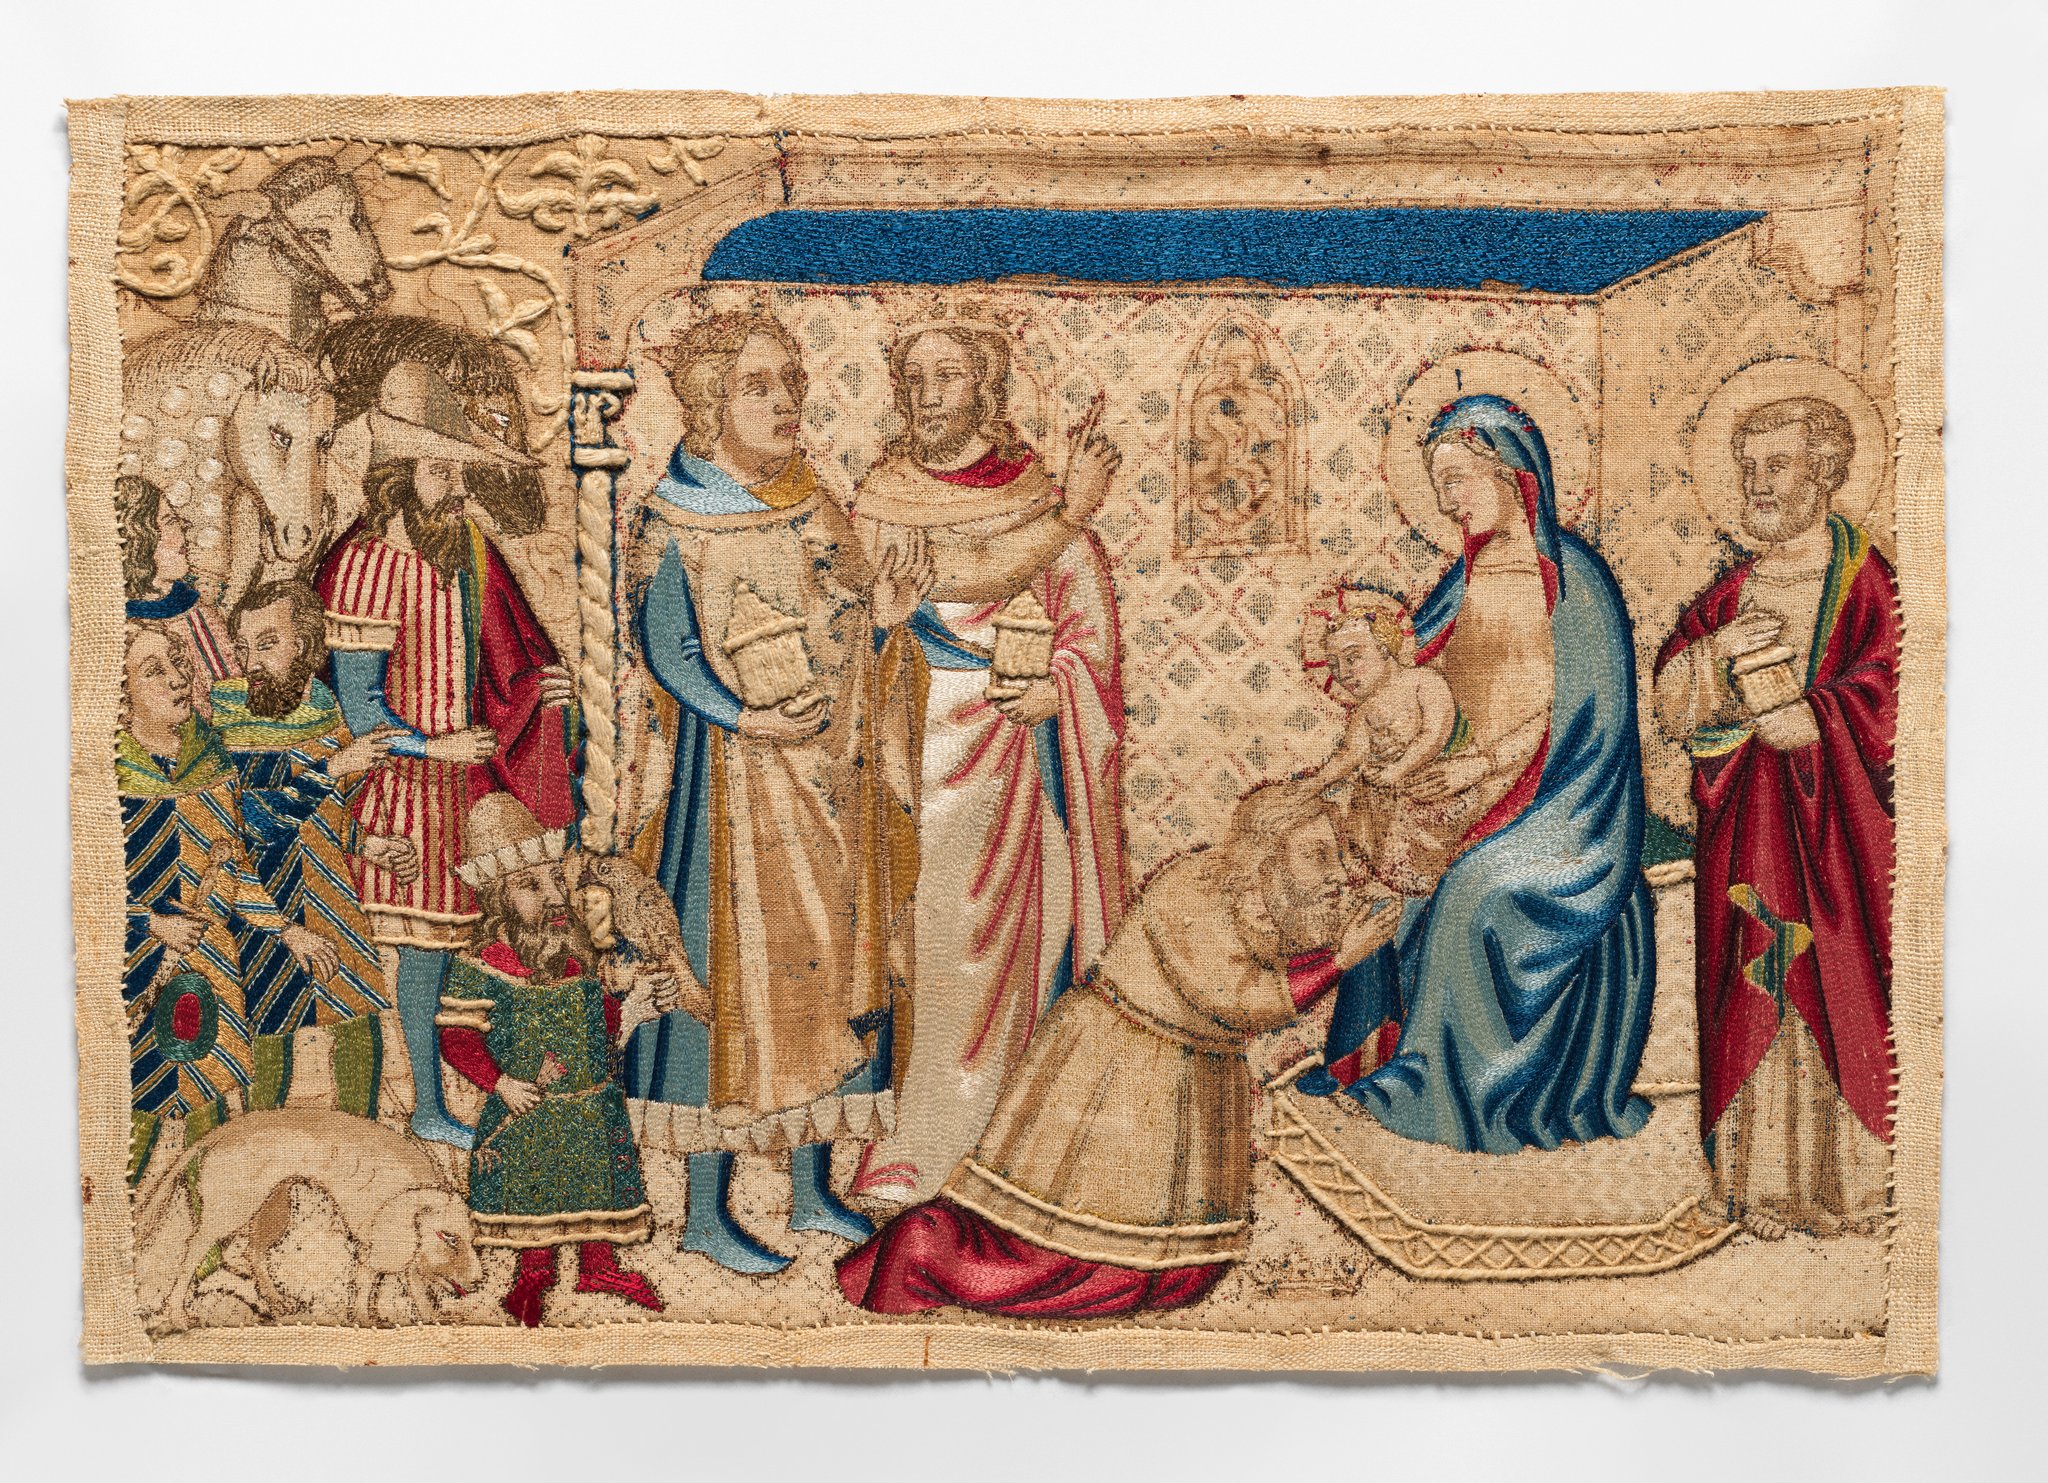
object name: orphrey, textile cover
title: The Adoration of the Magi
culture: italian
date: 1367-1400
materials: cotton, gilt, hemp, ink, linen, metal, silk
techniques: embroidery, laid work, weave, stitching, drawing, wash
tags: birds,men,dogs,horses,saint joseph,virgin mary